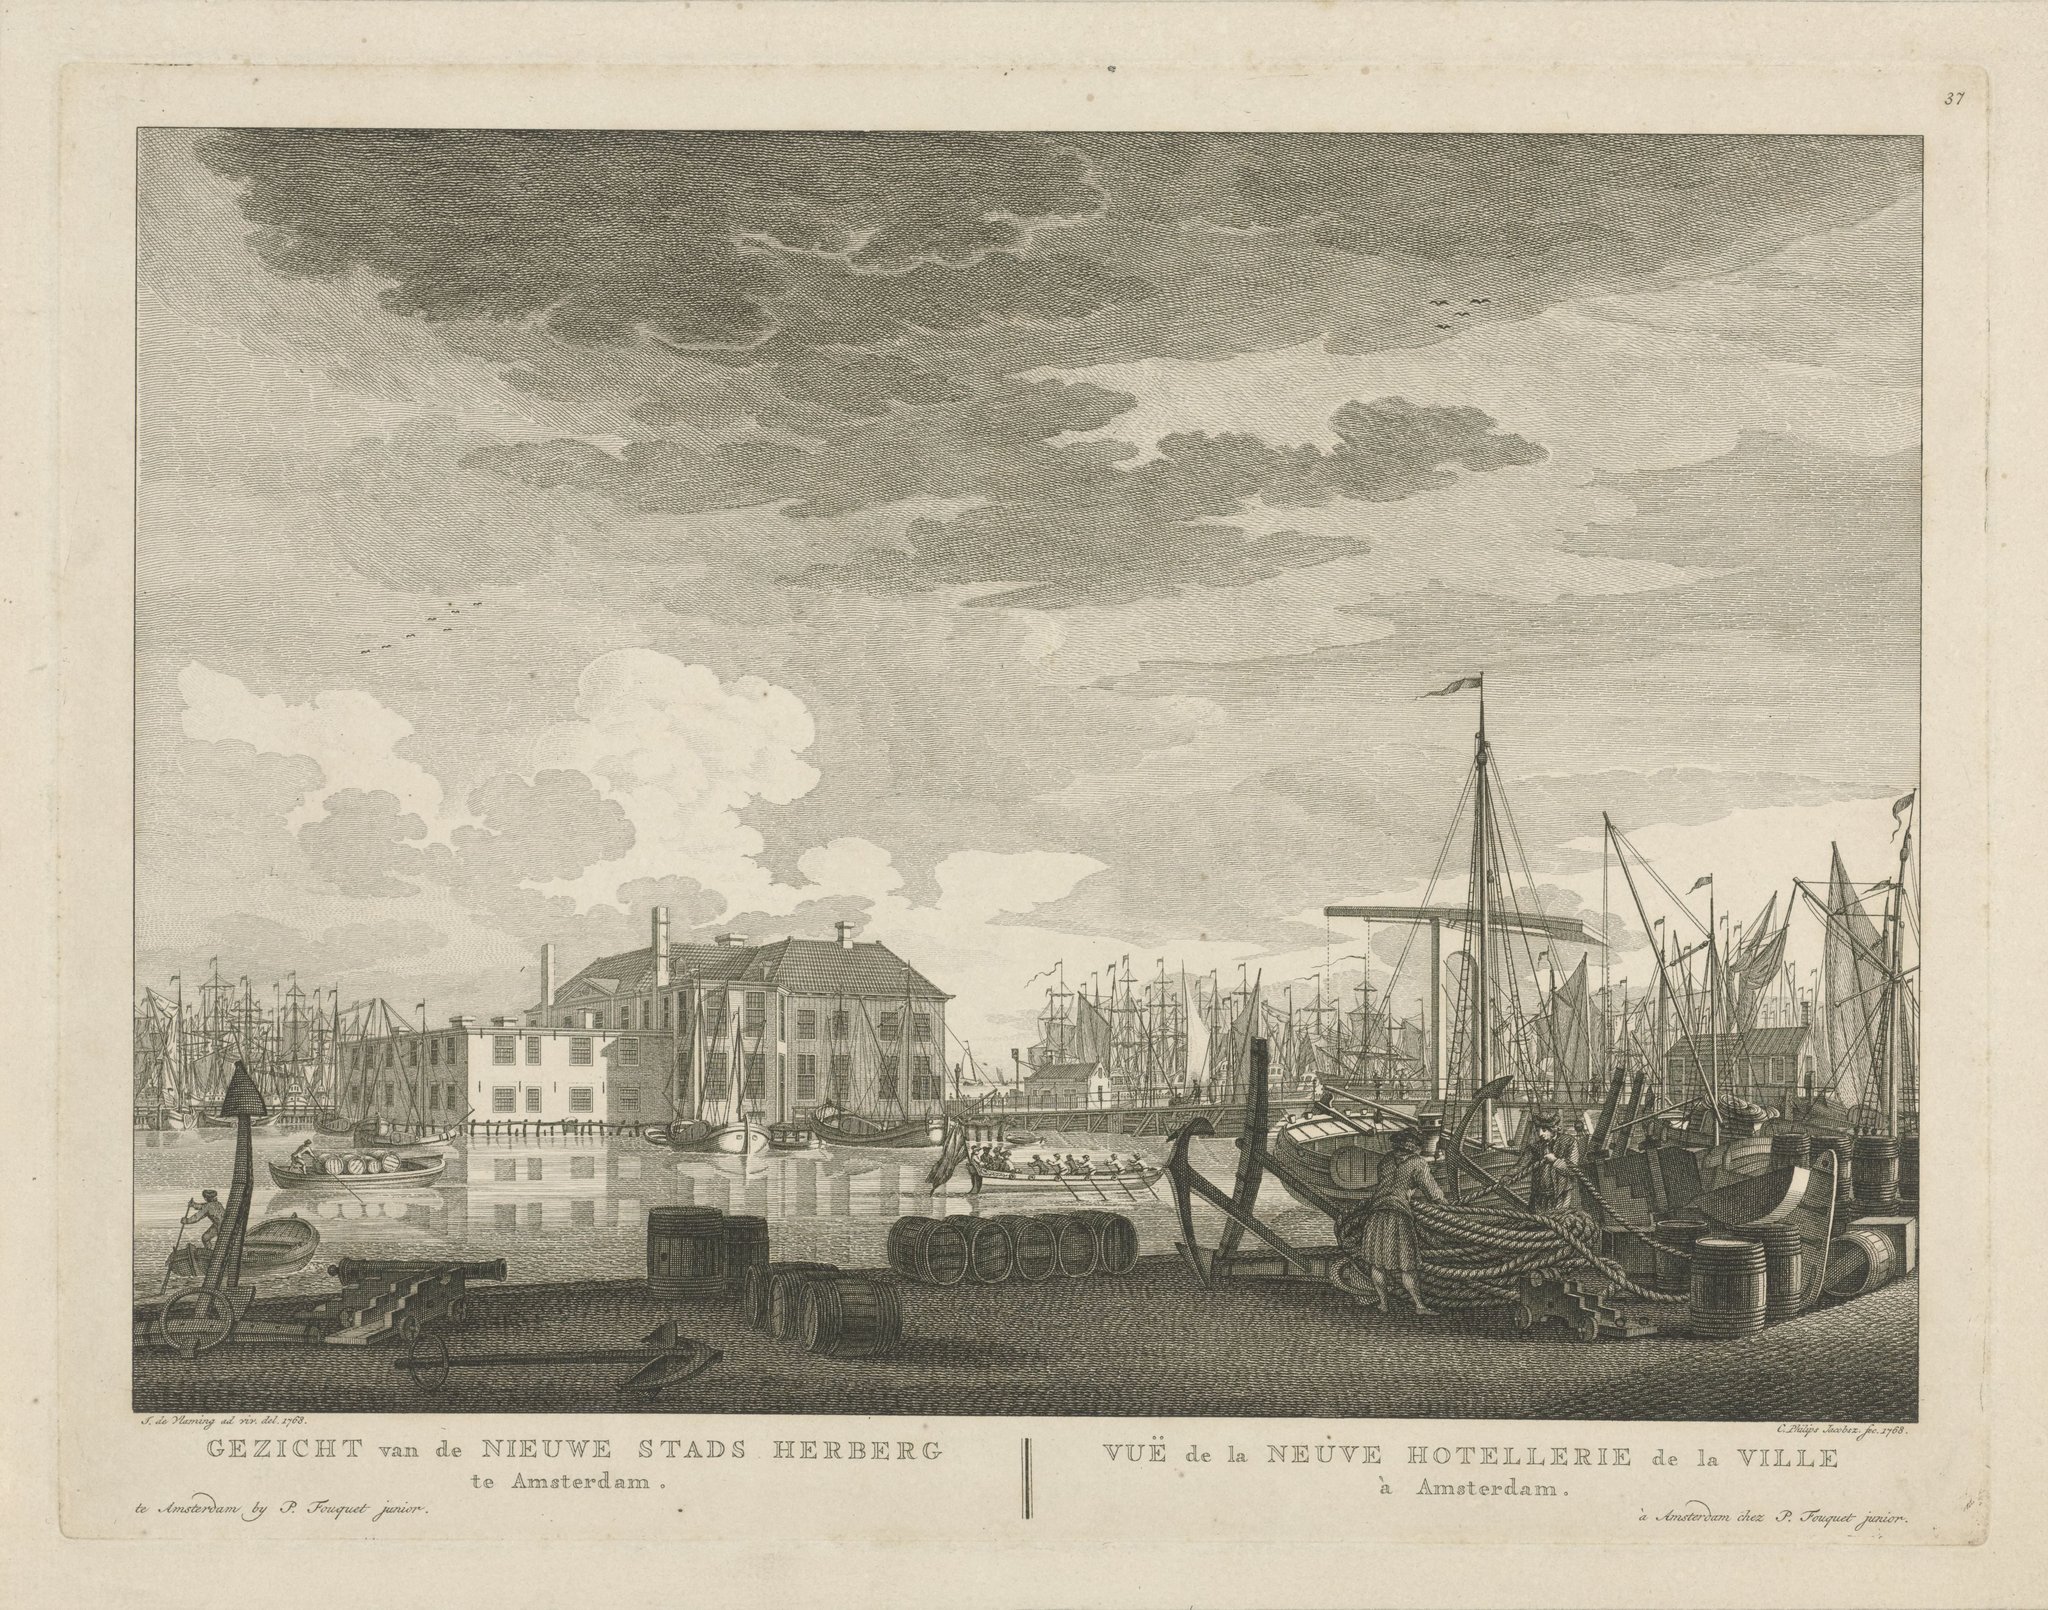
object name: print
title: Gezicht van de Nieuwe Stads Herberg te Amsterdam / Vuë de la Neuve Hotellerie de la ville á Amsterdam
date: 1768-1783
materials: paper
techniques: engraving, etching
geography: amsterdam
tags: harbour, ships (in general), pier, quay, wharf, hotel, hostelry, inn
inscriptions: collector's mark: Lugt 2228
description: Deze prent is ook gebruikt in de zogenaamde Atlas van Fouquet.* Pierre Fouquet gaf vanaf 1760 stadsgezichten van Amsterdam - naar tekeningen van verschillende kunstenaars, gemaakt door verschillende prentmakers - uit. Deze prenten werden aanvankelijk los of in series verkocht. Zoals toen gebruikelijk kon de koper de prenten zelf laten inbinden. Hiertoe gaf Fouquet tussen 1778 en 1783 een titelblad, plattegrond en inhoudsopgave van de tot dusver 100 uitgegeven prenten uit (1). Gezien de inhoud afhankelijk was van wat de koper had verzameld verschilt de inhoud van de verschillende bewaarde Fouquetatlassen onder deze titel sterk. Ook zijn er exemplaren bekend waar tevens andere prenten aan zijn toegevoegd. Omdat er behoefte bleek aan uitleg bij de platen werd in 1783 een nieuwe versie van de atlas uitgegeven, aangevuld met tekst en twee prenten. De aangegeven volgorde veranderde maar de platen van de al eerder uitgegeven prenten bleven ongewijzigd. Deze uitgave werd in opdracht van Fouquet gedrukt bij Daniël Jean Changuion en Petrus den Hengst (2). Een tiental platen werd bijgewerkt en verscheen, met nieuw impressum, in het vervolg van Wagenaars geschiedenis van Amsterdam, uitgeven door Petrus Conradi en Folkert van der Plaats (3). Een aantal jaar na het overlijden van Fouquet kwam Evert Maaskamp met een nieuwe uitgave van de atlas, met verbeterde tekst en toevoeging van twee prenten. Op alle platen verwijderde hij het oude en liet hij zijn eigen impressum zetten (4). De huidige staat van de prent komt voor in exemplaren van de onder (1) en (2) genoemde werken. * Onder de Atlas van Fouquet of Fouquetatlas verstaan we de hieronder vermelde publicaties (1), (2) en (4). (1). Afbeeldingen van de wyd-vermaarde koopstad Amsterdam benevens des zelvs voornaamste gebouwen en gezigten alle naar het leeven getekend / Receuil des edifices les plus considerables et des plus belles vues, de la fameuse ville d'Amsterdam, dessinées d'après nature. Amsterdam: Pierre Fouquet, 1778-1783. (2). Nieuwe atlas, van de voornaamste gebouwen en gezigten der stad Amsterdam, met derzelver beknopte beschryvingen. 2 delen. Amsterdam: Daniël Jean Changuion en Petrus den Hengst [in opdracht van Pierre Fouquet], 1783. (3). Stijl, Simon. Amsterdam, in zyne geschiedenissen, voorregten, koophandel, gebouwen, kerkenstaat, schoolen, schutterye, gilden en regeeringe, beschreeven. Om te dienen ten vervolge op het werk van Jan Wagenaar (…). 10 delen. Amsterdam en Harlingen: Petrus Conradi en Folkert van der Plaats, 1788-1801. (4). Nieuwe atlas, van de voornaamste gebouwen en gezigten der stad Amsterdam. Met derzelver beknopte beschryvingen. Amsterdam: Evert Maaskamp, 1805. * Het aantal vermelde staten is gebaseerd op het aantal gevonden staten. Mogelijk zijn er meer staten van deze prent. Voor andere staat zie RP-P-AO-25-31.